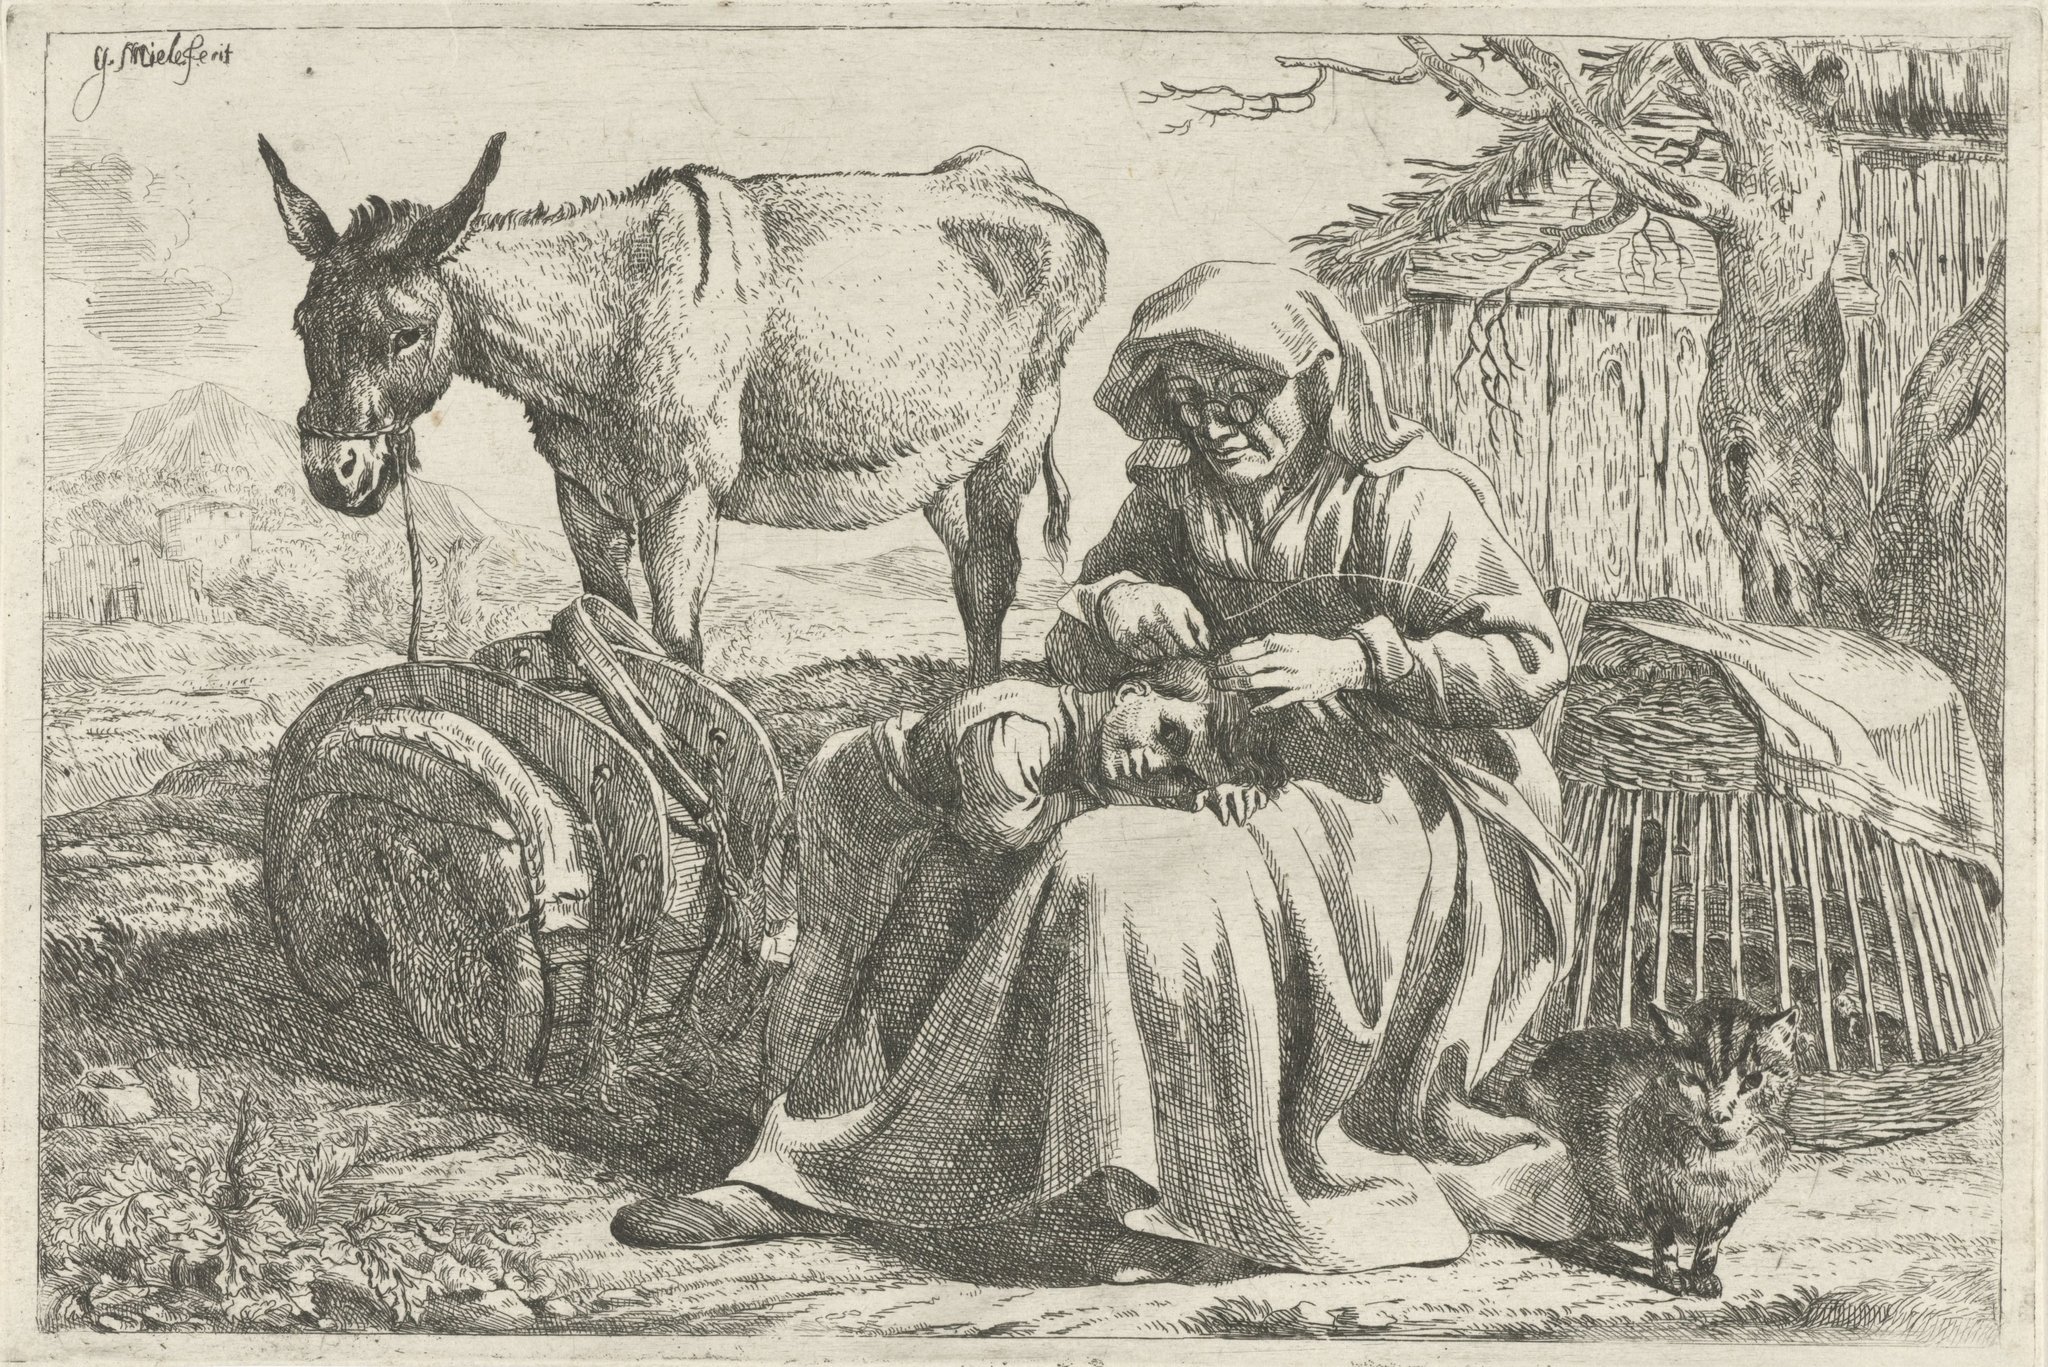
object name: print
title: Oude vrouw die een kind luist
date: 1599-1664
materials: paper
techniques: etching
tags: cat, ass, donkey, old woman, looking for fleas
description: Een oude vrouw met een lorgnet op haar neus luist een kind, dat met zijn hoofd op haar schoot ligt. Naast haar een kat en een omgekeerde mand, waaronder een vogel zit. Links een afgezadelde ezel.